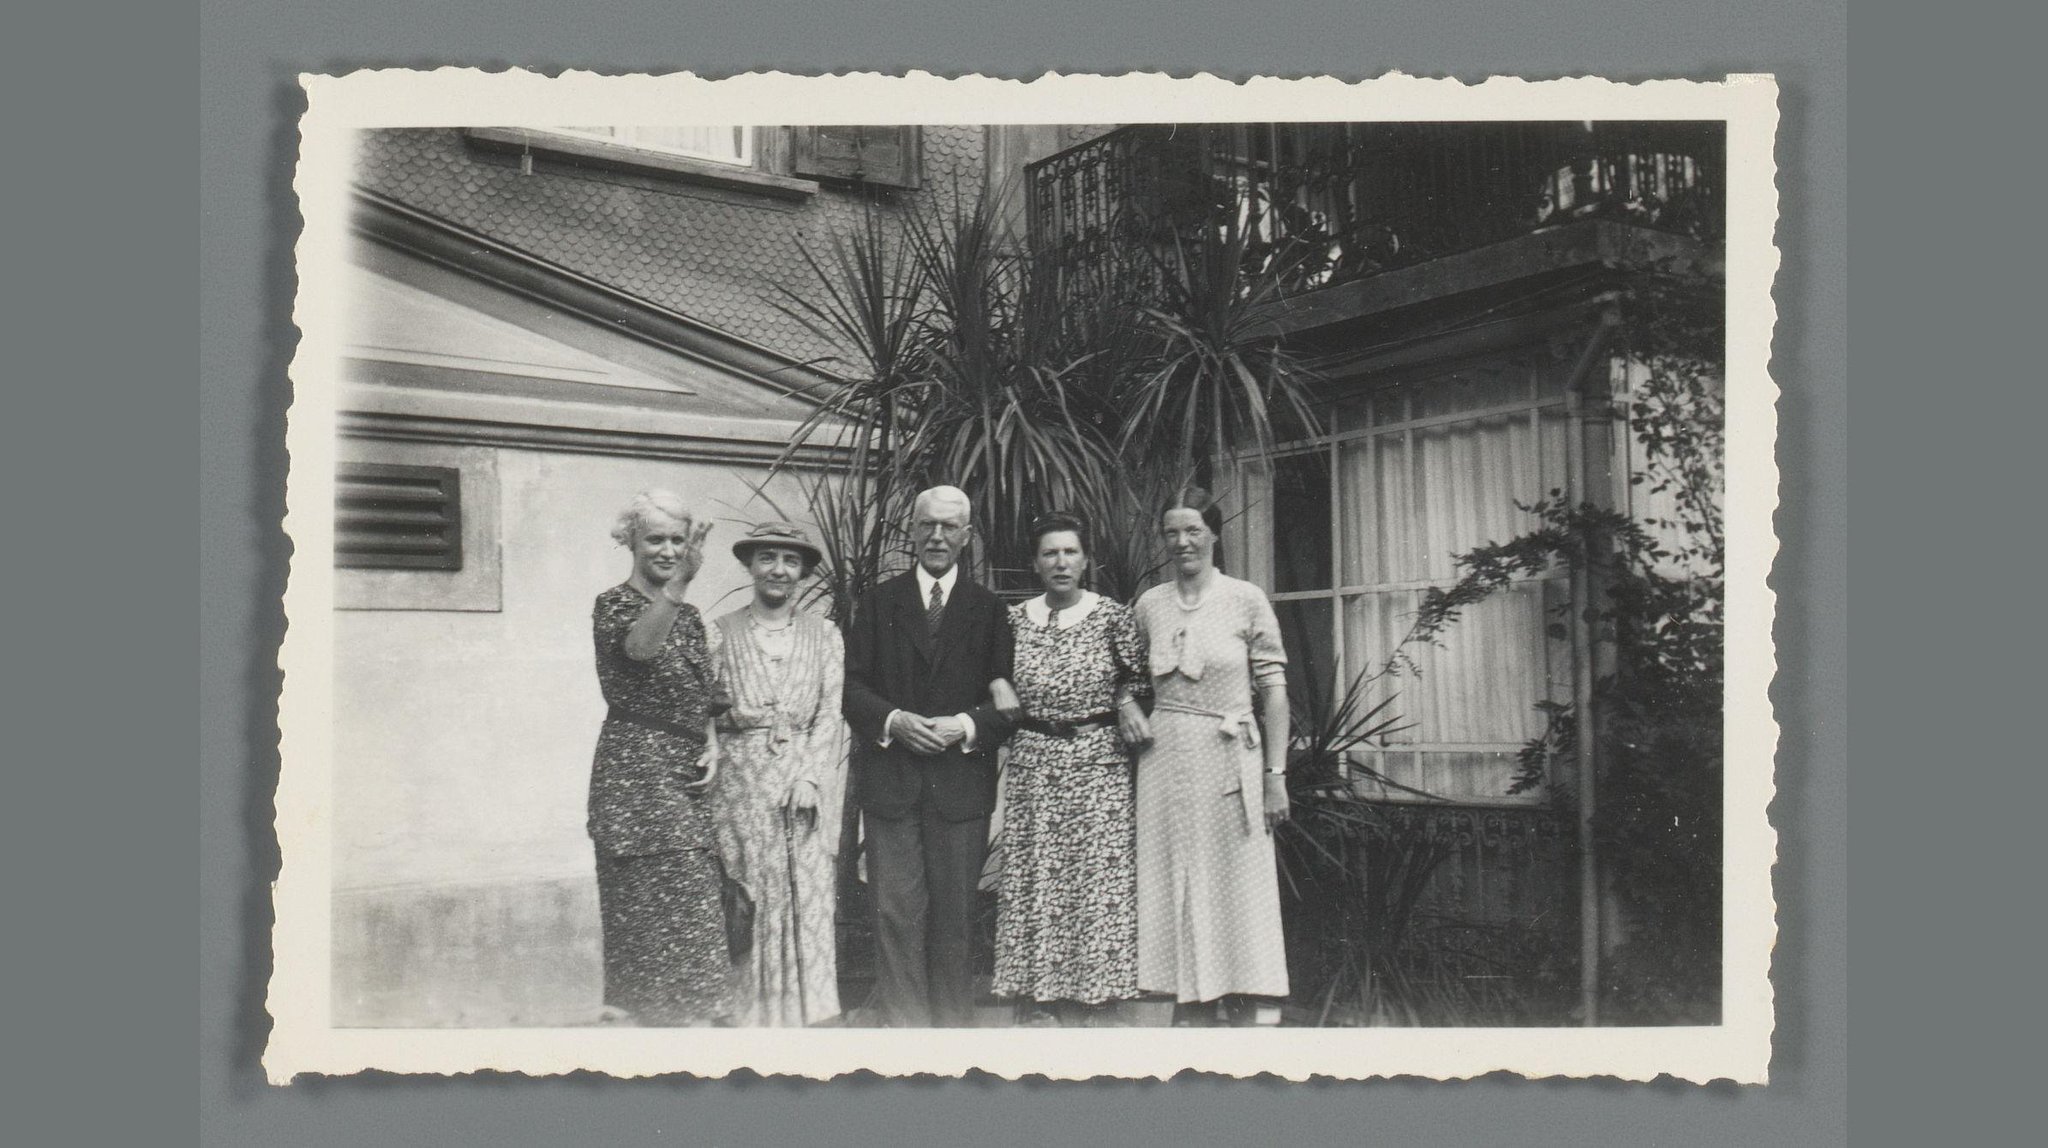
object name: photograph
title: Groepsportret van vier vrouwen en een man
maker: a. wolffenspercher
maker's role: fotograaf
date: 1908-1939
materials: paper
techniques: gelatin silver print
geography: herisau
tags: hannie holtzscher, arm in arm (friends), historical persons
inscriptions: inscription: ‘Aug. '39/ Tuin v. Heinrichsbad/ Hannie Holtzscher/ G. Manson/ Dr. Weststrate/ Gr. v. Geelen[?]/ Annie Weststrate/ Photo A. Wolffensperger’